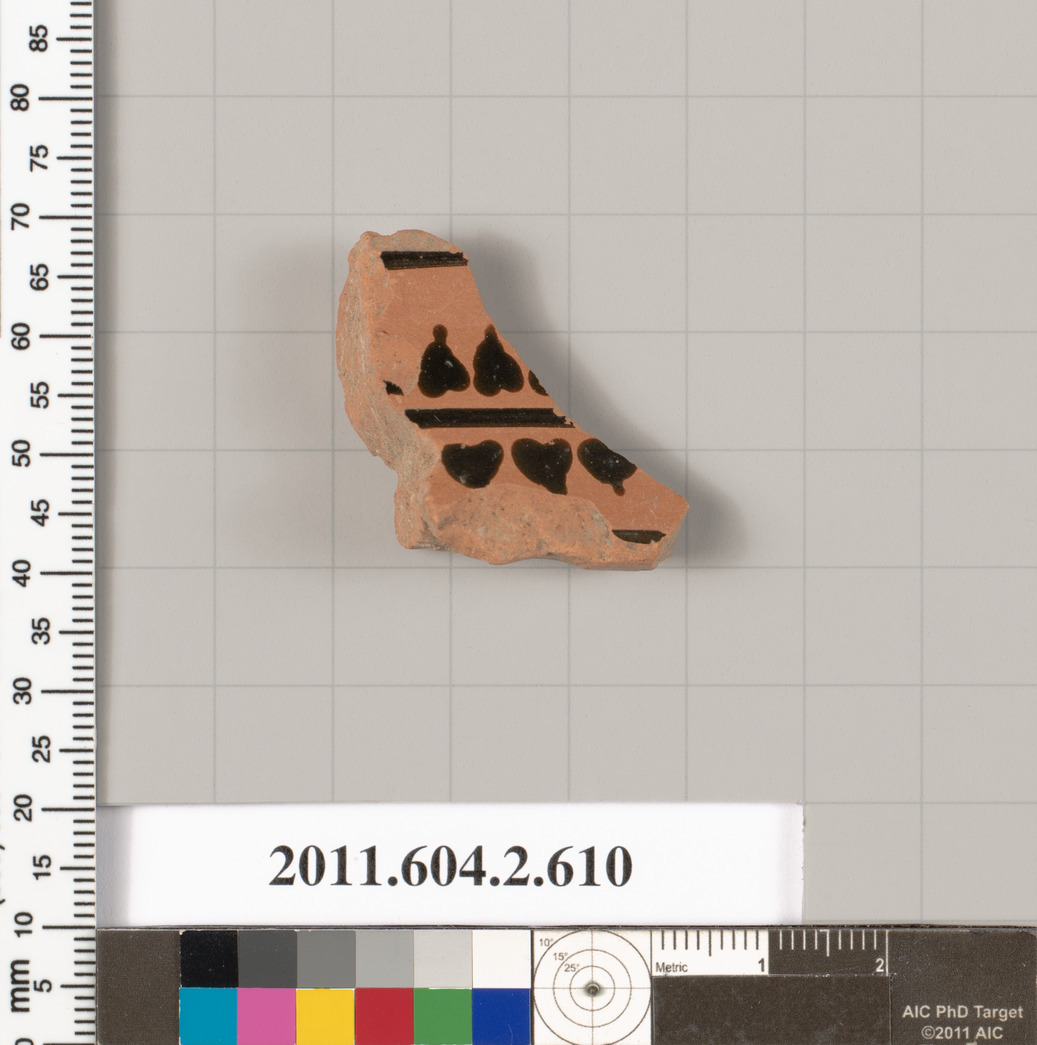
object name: column krater fragment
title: Terracotta fragment of a column-krater (bowl for mixing wine and water)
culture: greek, attic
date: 475-451 BCE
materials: terracotta